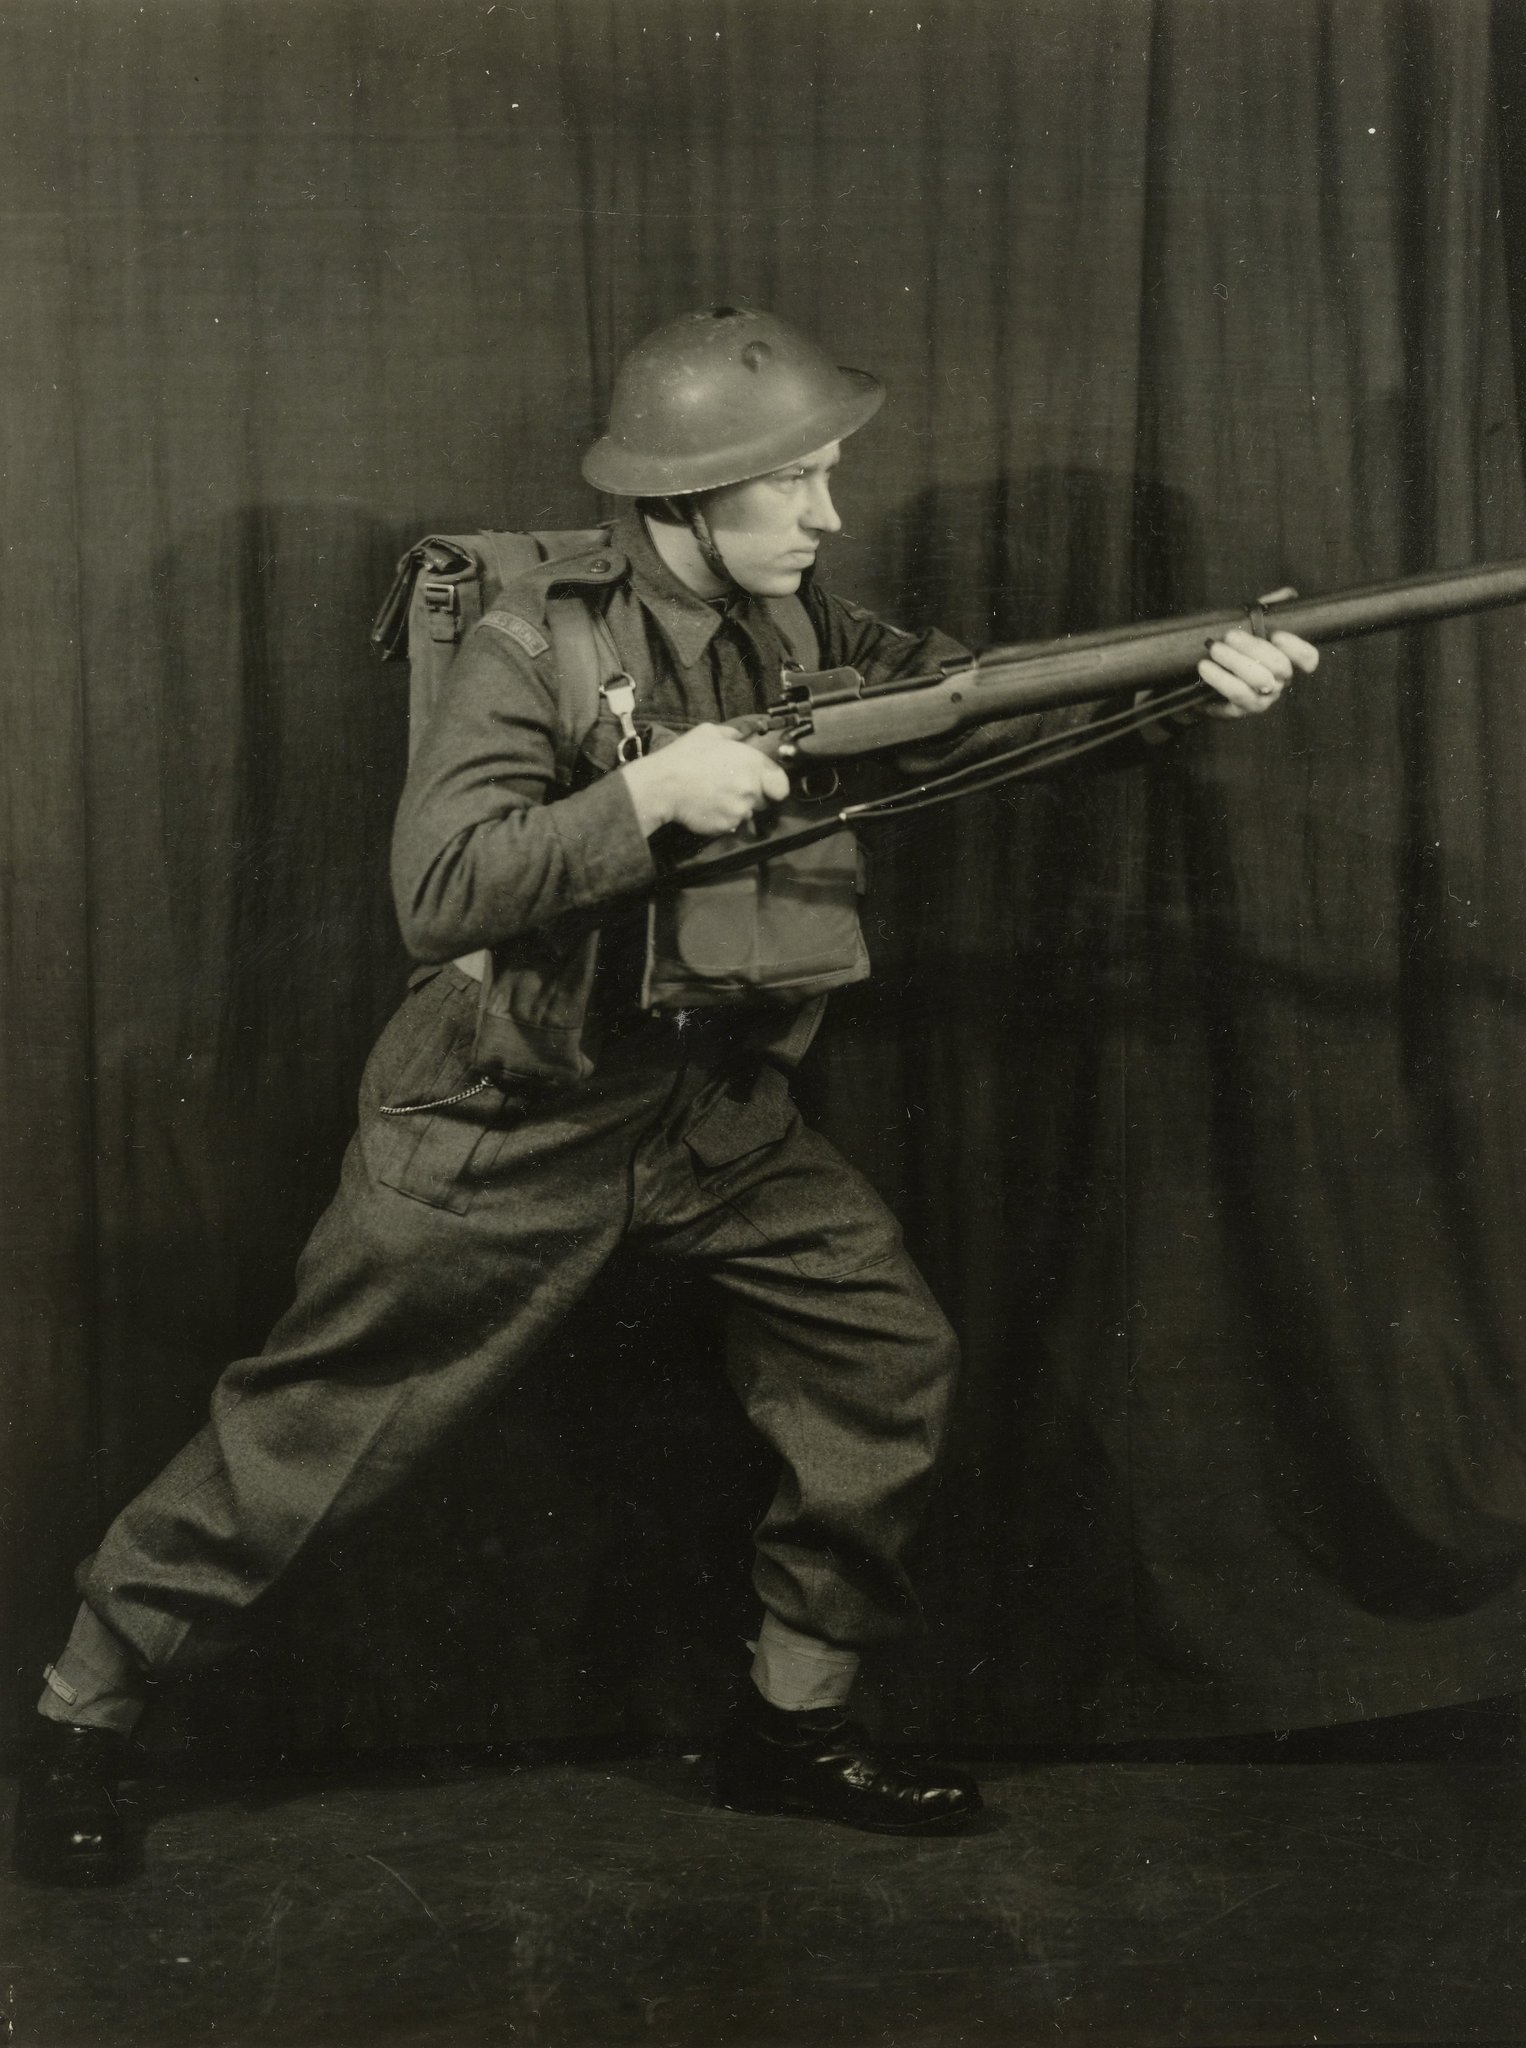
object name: photograph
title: Militair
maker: a.c. cooper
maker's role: fotograaf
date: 1940-1945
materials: photographic support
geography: london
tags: london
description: Een Nederlandse militair poseert voor een gordijn met een karabijn in zijn handen. Hij is ten voeten uit gefotografeerd. Cor Visser wilde deze foto waarschijnlijk gebruiken voor een van zijn tekeningen